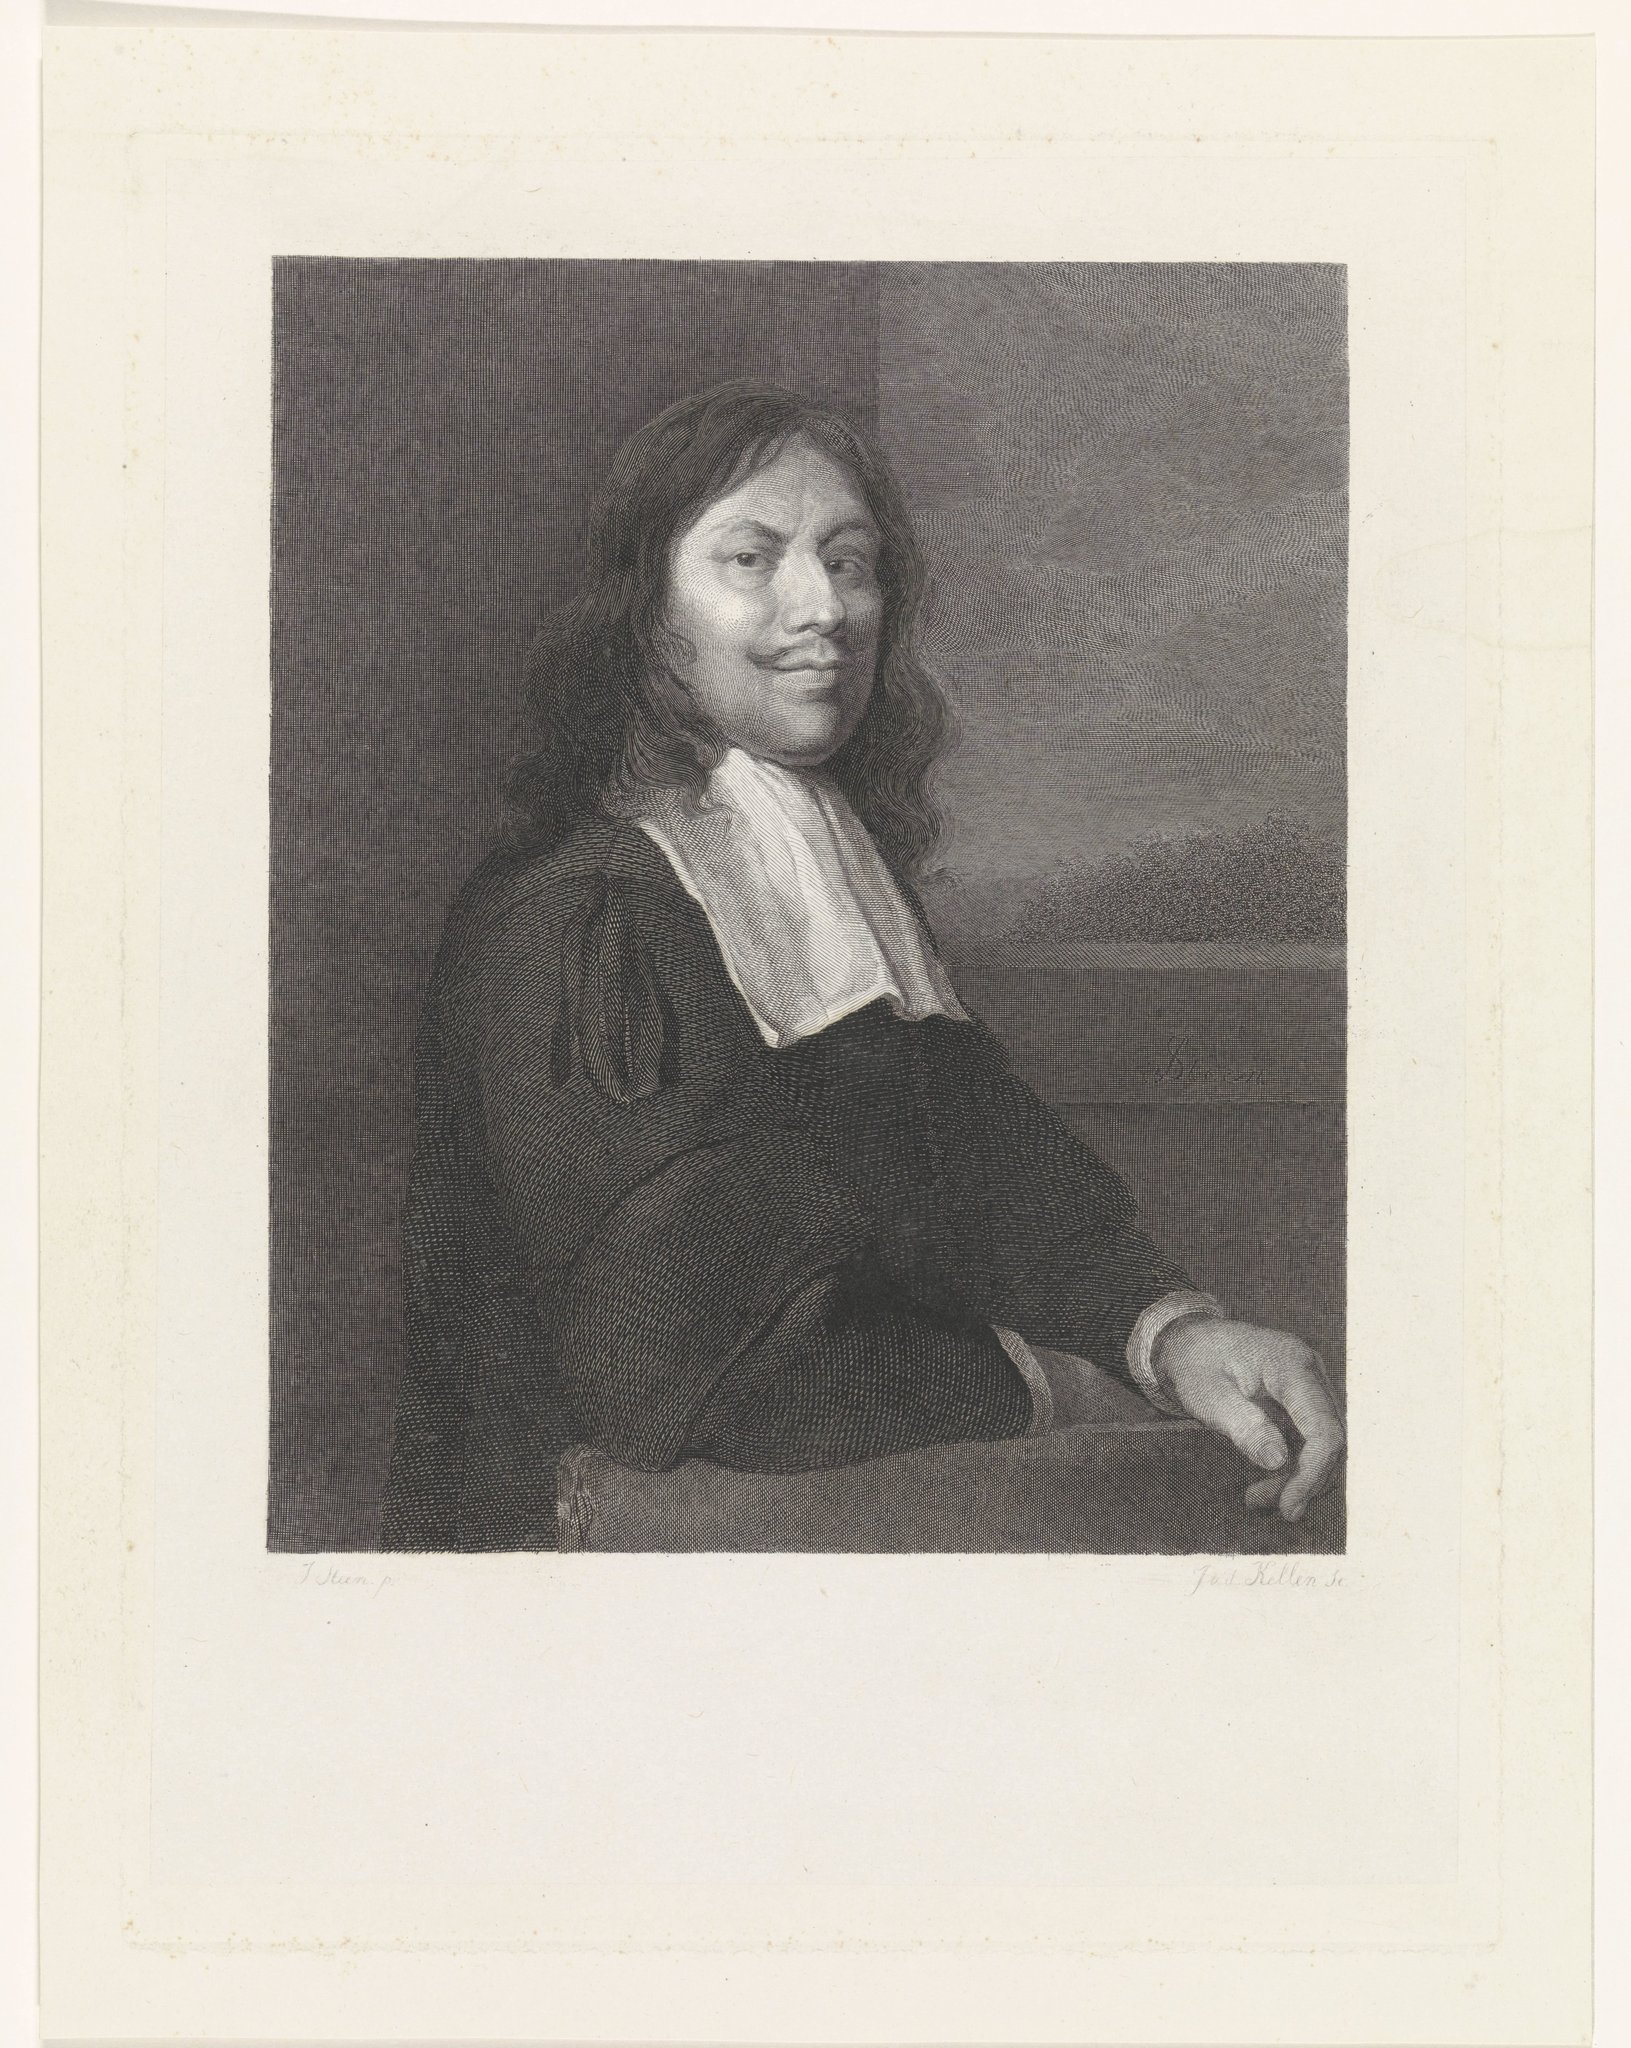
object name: print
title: Portret van Jan Havicksz. Steen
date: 1853-1895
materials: paper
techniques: engraving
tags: leiden, painter, jan havicksz. steen, portrait, self-portrait of painter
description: Portret ten halven lijve naar rechts van de zeventiende-eeuwse schilder Jan Steen, met zijn elleboog op een stoel leunend en zijn blik op de toeschouwer gericht.